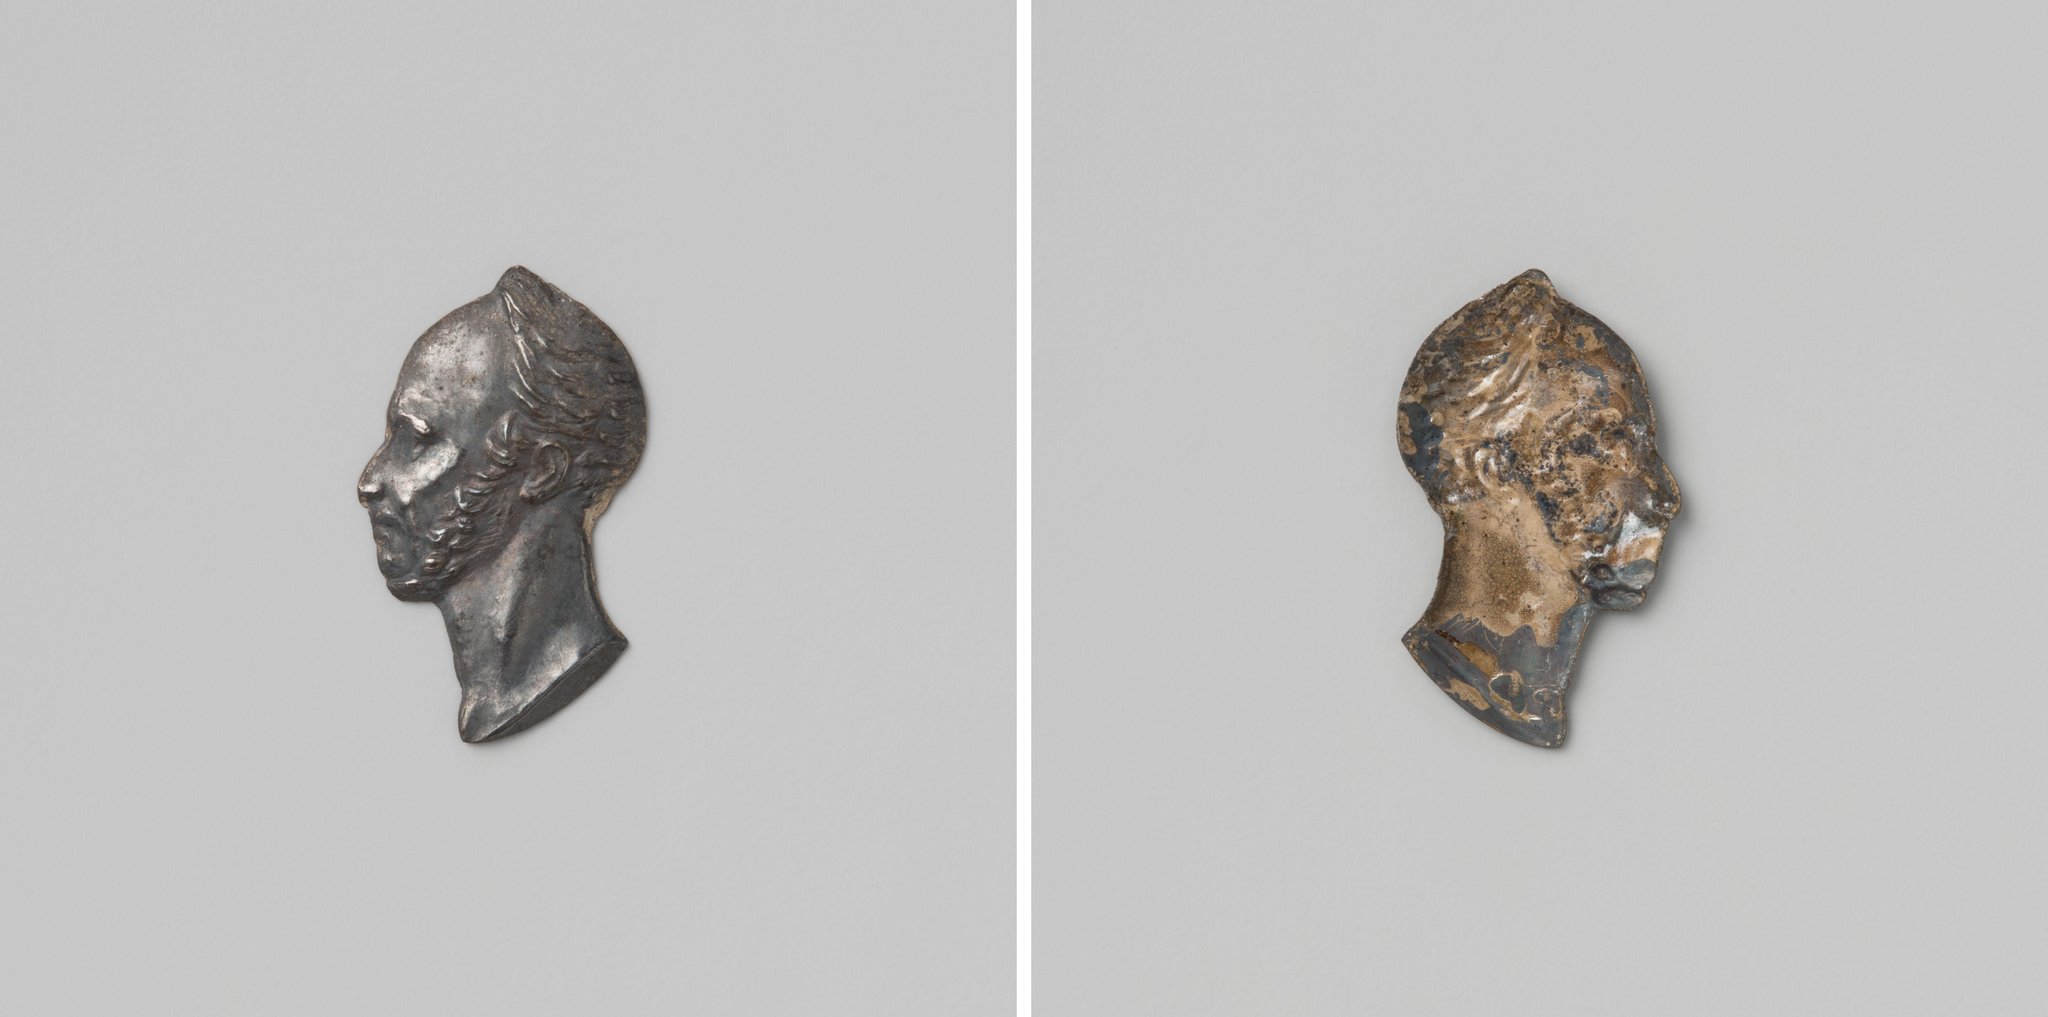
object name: insignia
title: Vijftigjarige viering van slag bij Waterloo, draagteken ter ere van Willem II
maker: Anonymous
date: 1865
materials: silver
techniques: striking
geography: netherlands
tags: the hague, william ii of the netherlands, waterloo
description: Eenzijdig zilveren draagteken, bestaande uit borststuk man naar links